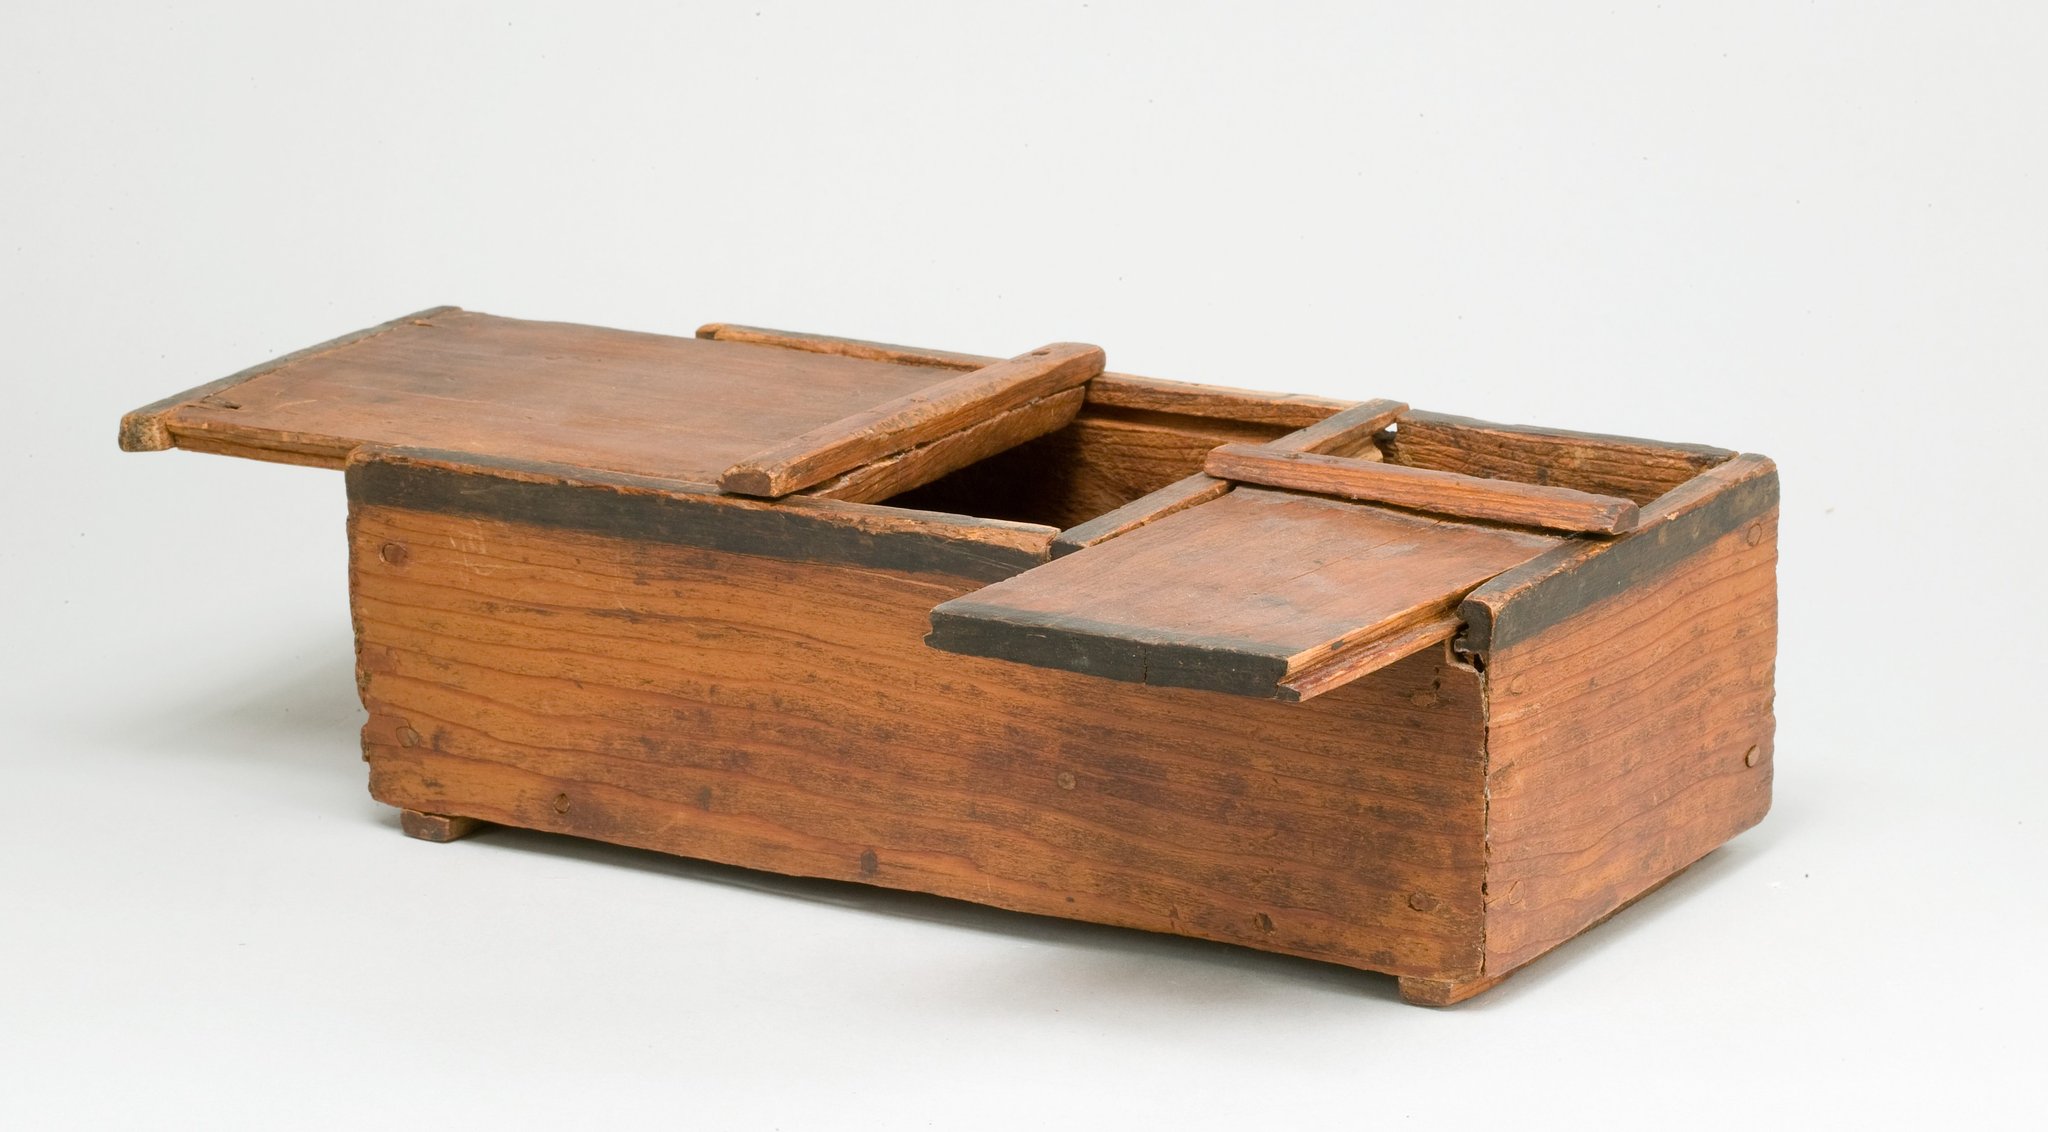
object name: jewelry box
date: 2051-1981 BCE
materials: wood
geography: egypt